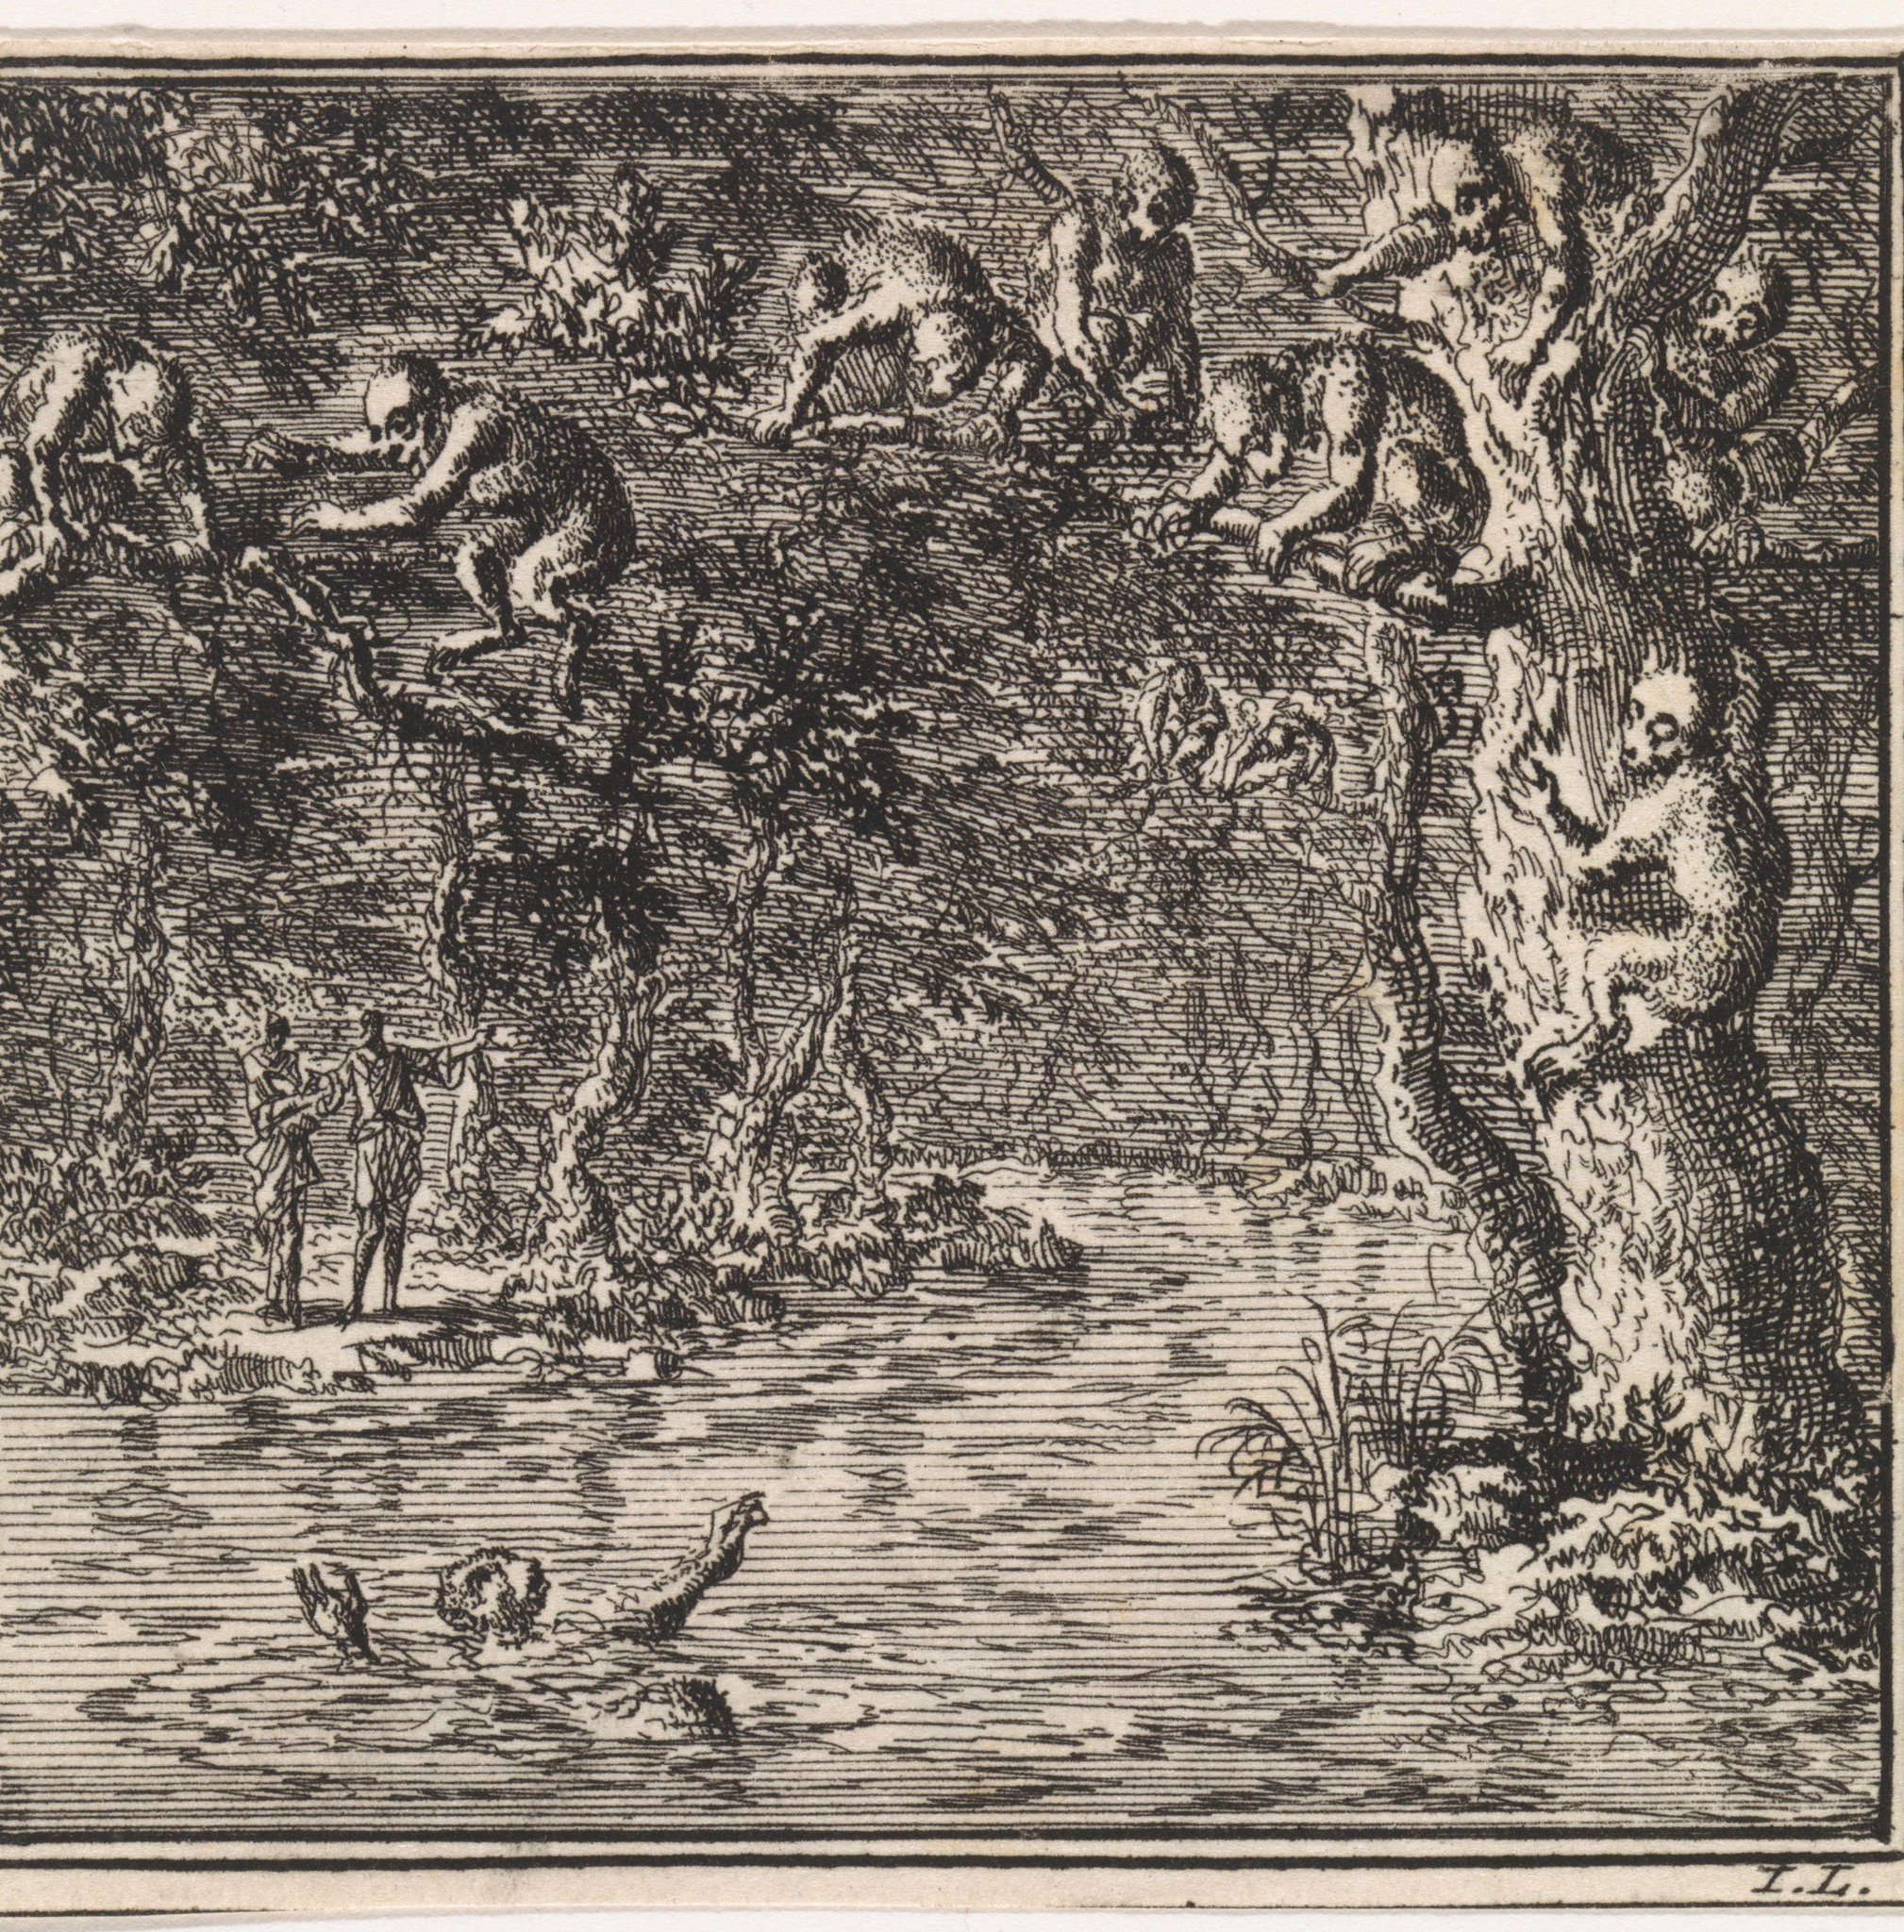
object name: book illustration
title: De Aapen-vreugd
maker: jan luyken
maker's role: draughtsman, print maker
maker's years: 1649-1712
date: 1711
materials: paper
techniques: etching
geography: amsterdam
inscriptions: collector's mark: Lugt 2228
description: Illustratie voor: Luyken, Jan. De Bykorf des Gemoeds. Amsterdam: Pieter Arentsz. II (wed.) en Cornelis van der Sys, 1711, p. 162.